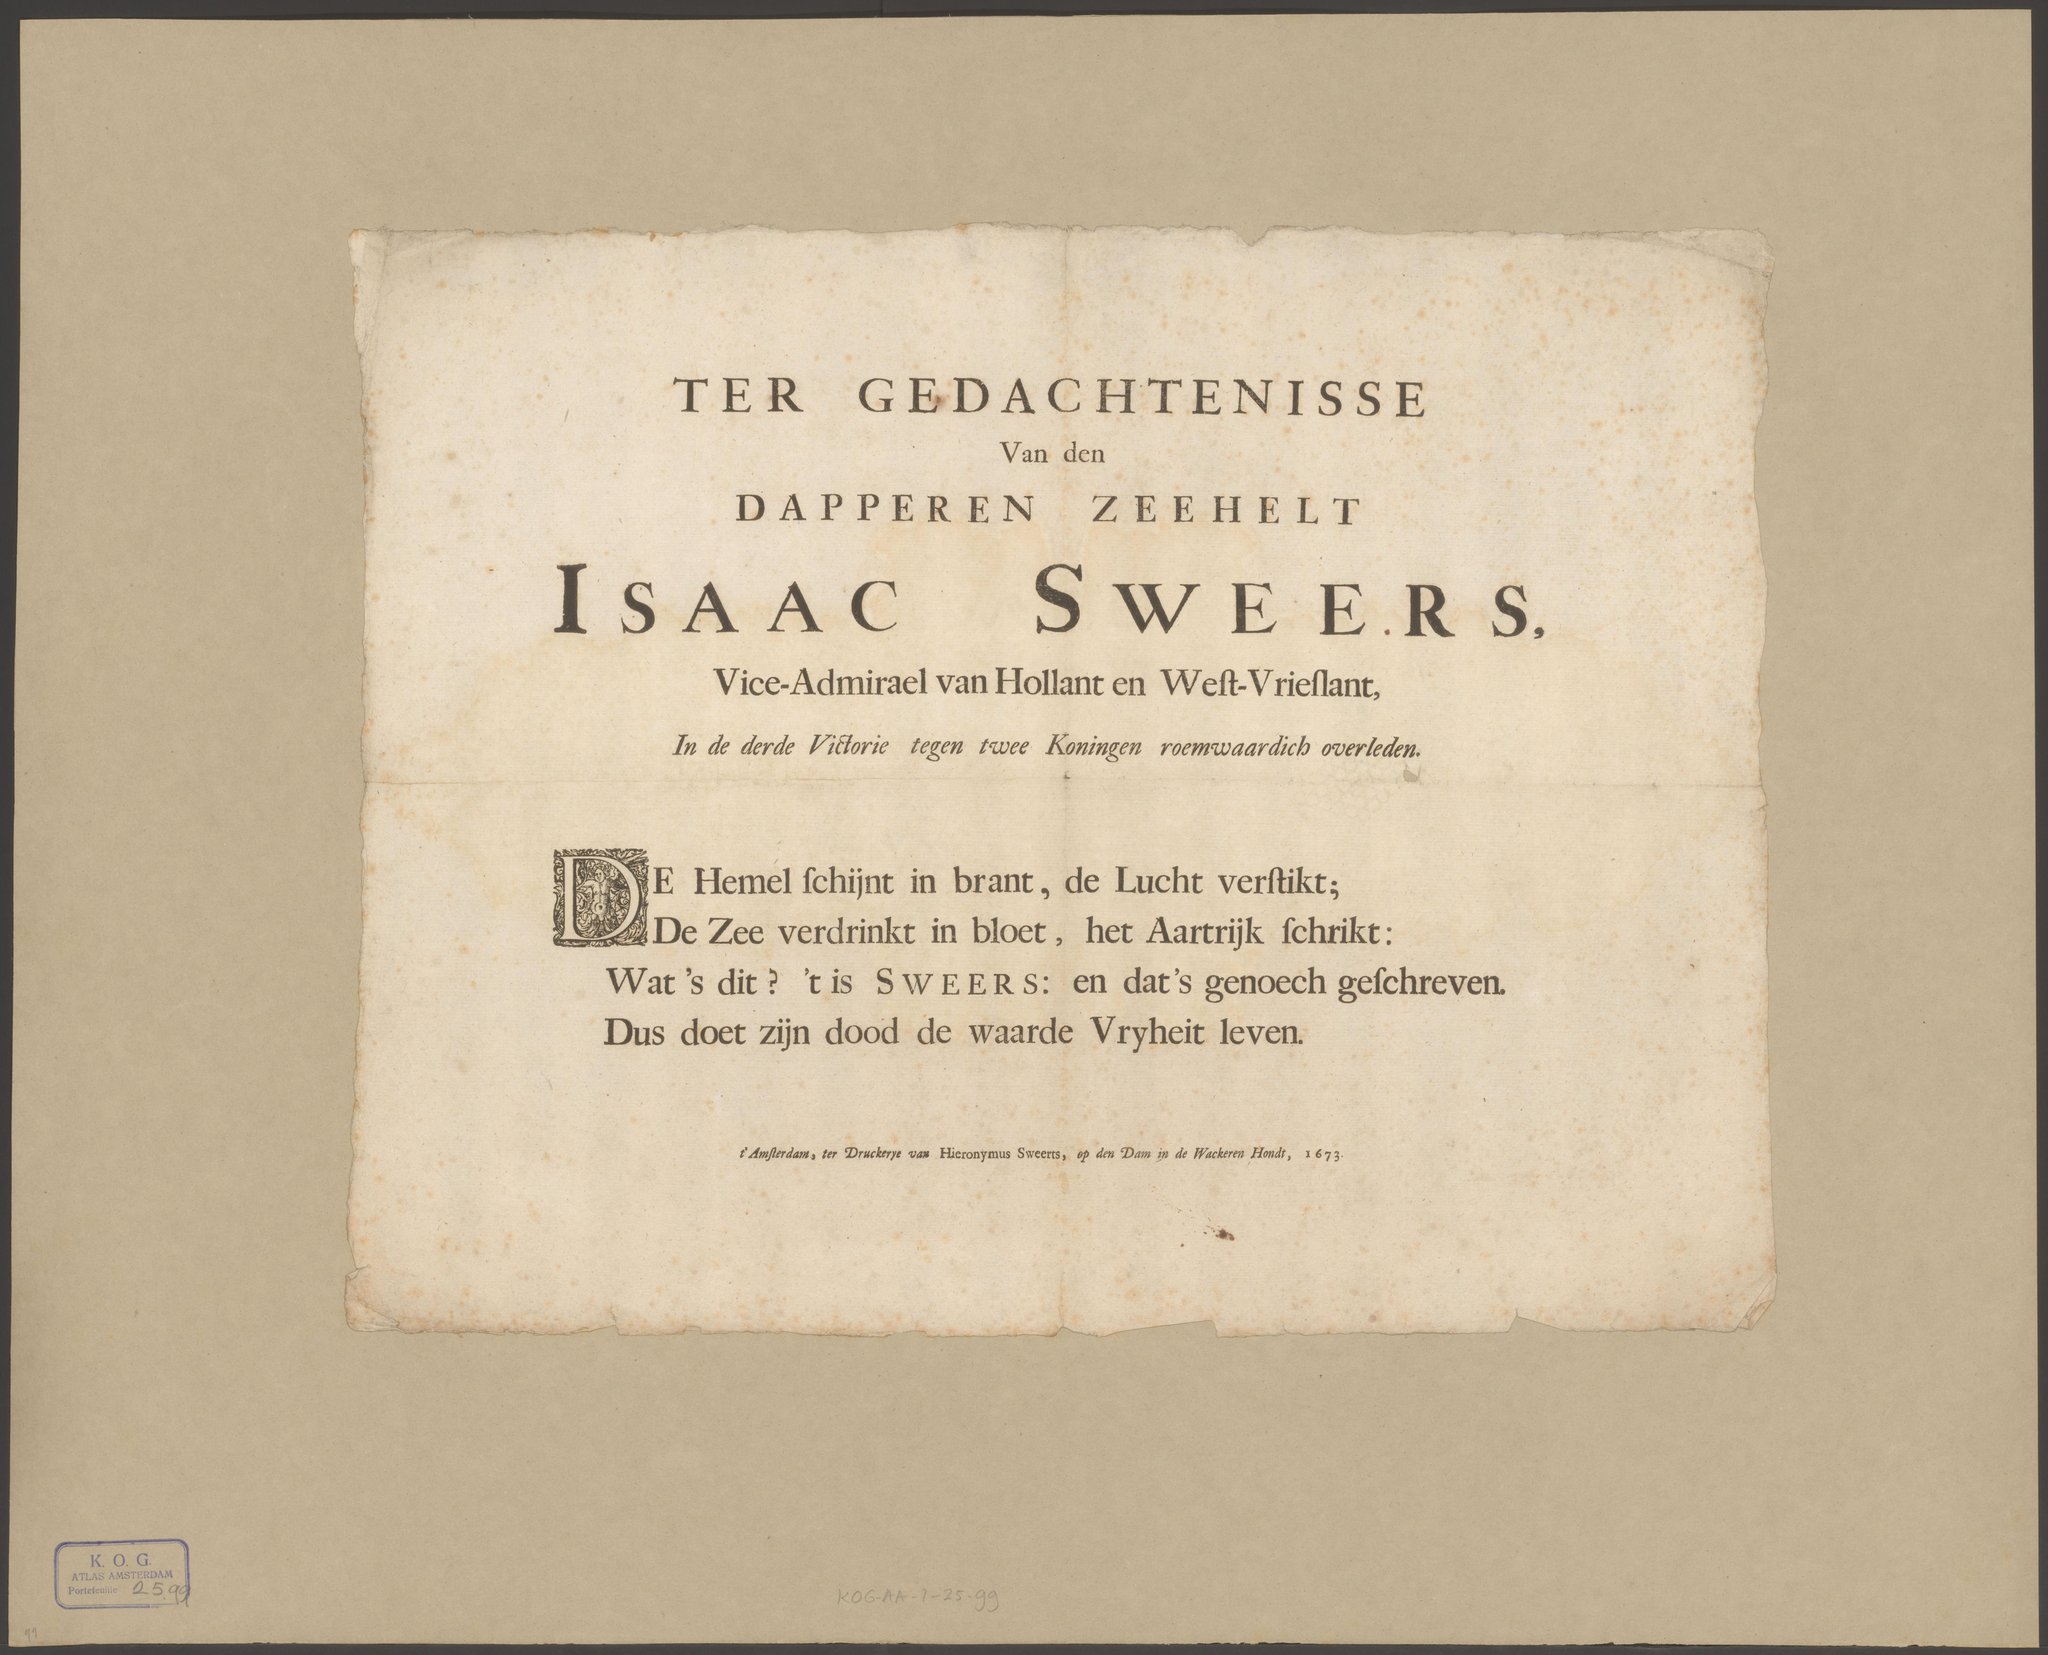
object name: text sheet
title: Gedicht ter nagedachtenis aan Isaac Sweers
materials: paper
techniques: letterpress printing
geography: amsterdam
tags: nijmegen, burial, historical persons, commander-in-chief, admiral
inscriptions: collector's mark: ‘25.99’ Lugt 1641b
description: Onderwerpsrubriek binnen de Atlas Amsterdam: Krijgswezen I: De Admiraliteit van Amsterdam, B. Vlootvoogden en schepelingen; Herinneringen daaraan.